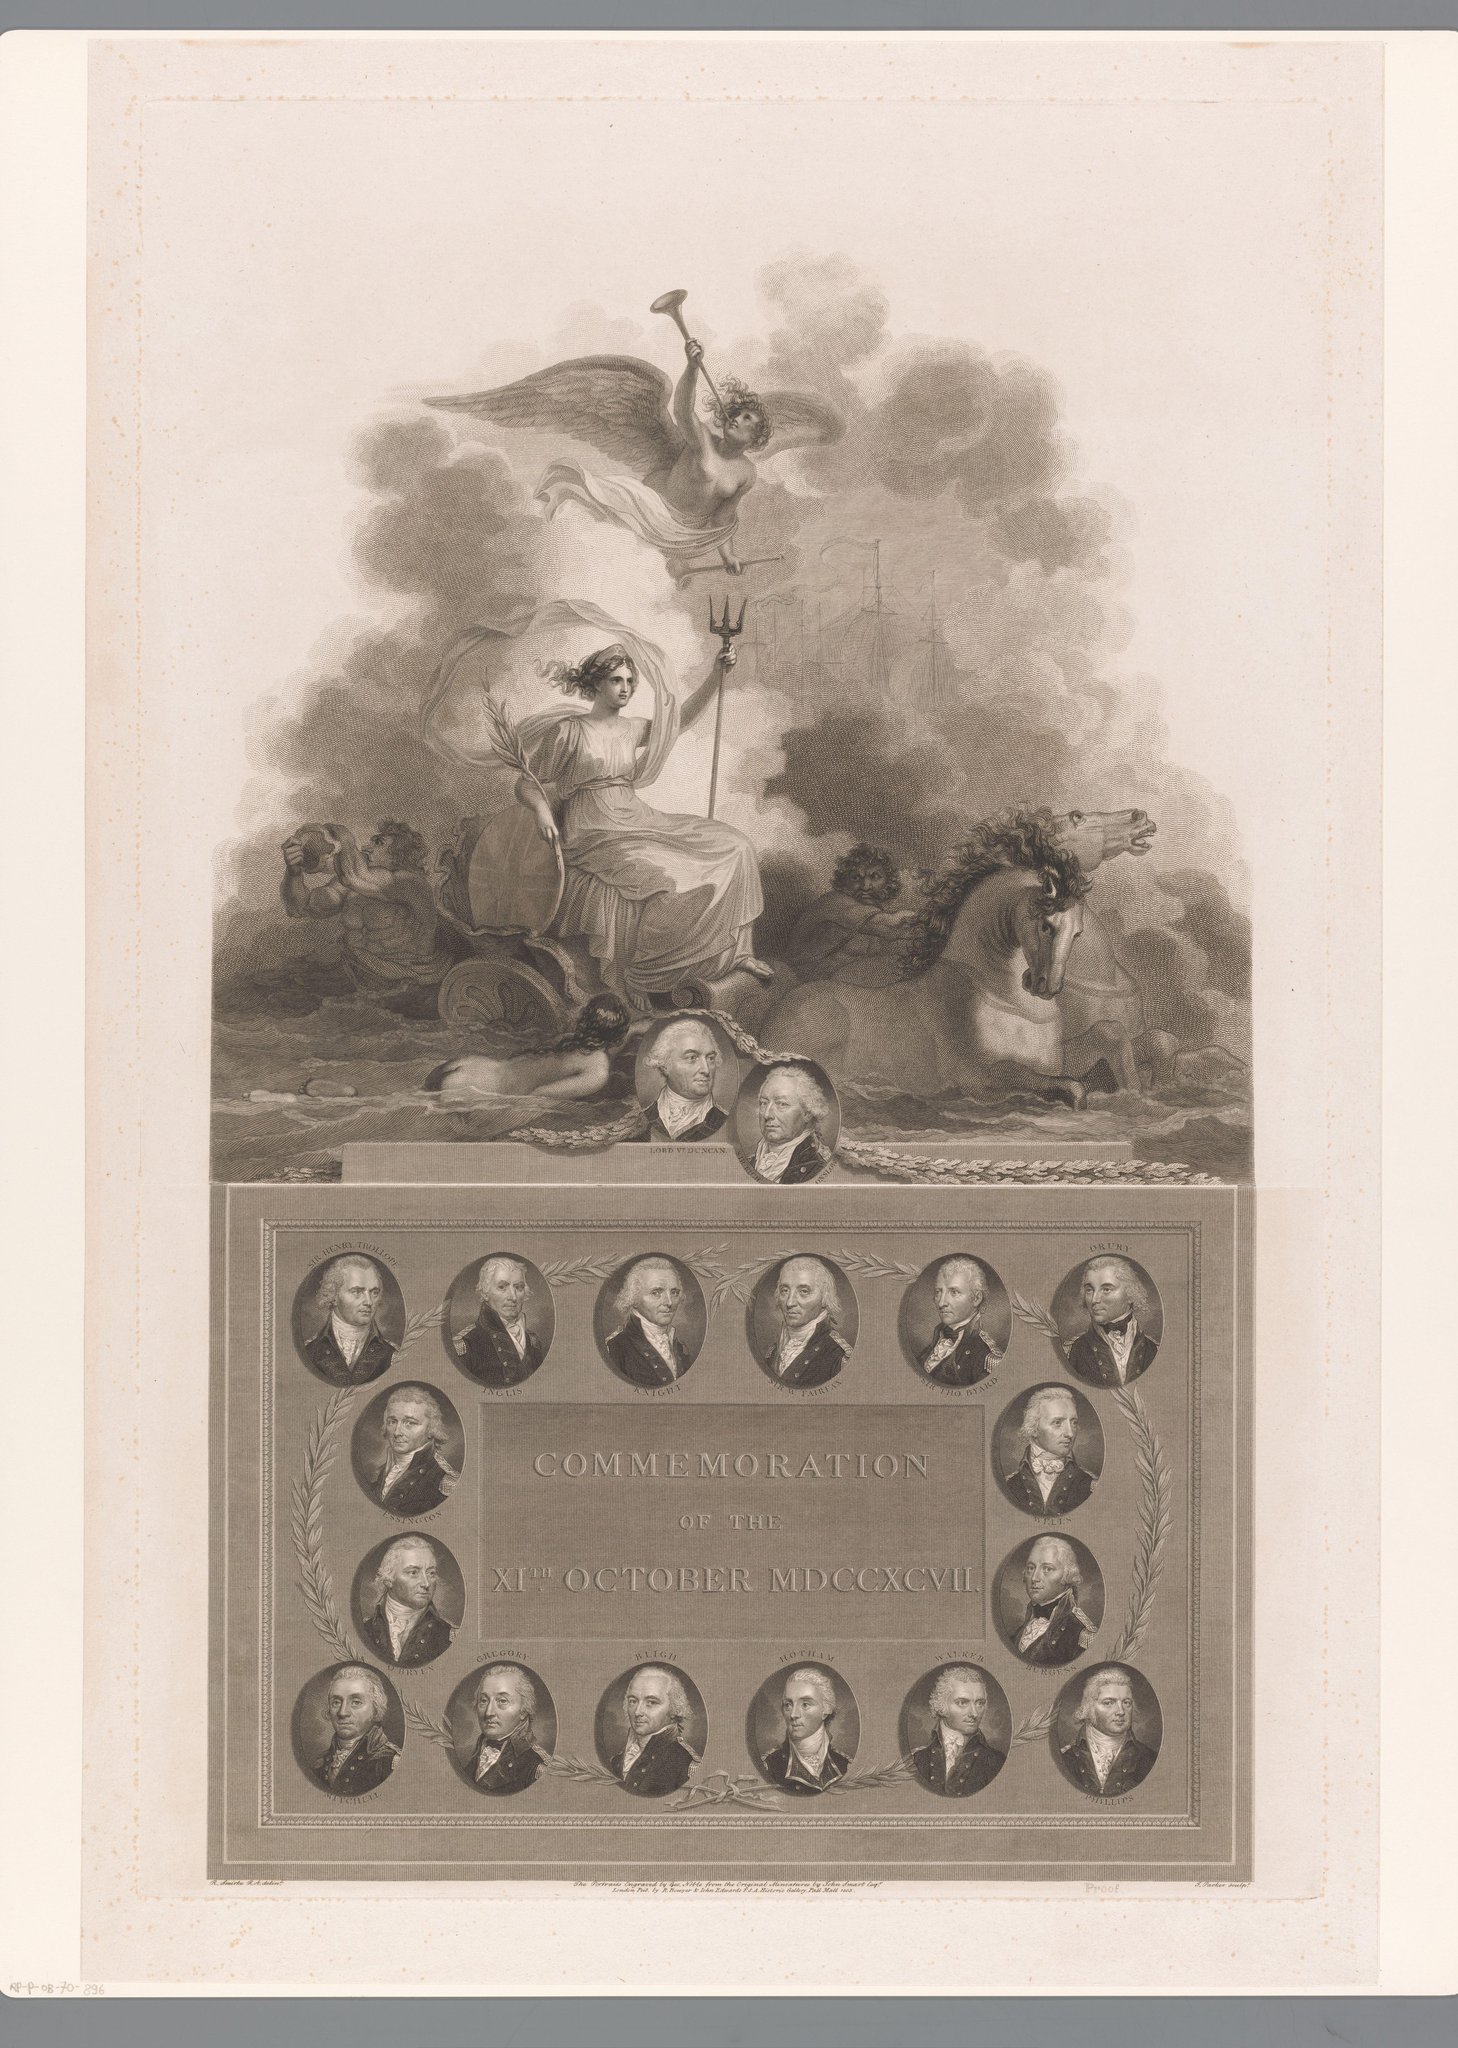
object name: print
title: Personificatie van Britannia en achttien portretten op een plakkaat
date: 1803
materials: paper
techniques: engraving, etching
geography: london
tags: plymouth, william bligh, adam duncan (burggraaf van duncan), personifications of countries, nations, states, districts, etc., historical persons, commander-in-chief, admiral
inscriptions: collector's mark: Lugt 12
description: Engelse admiraals en officiers die deelnamen in de Zeeslag bij Camperduin.